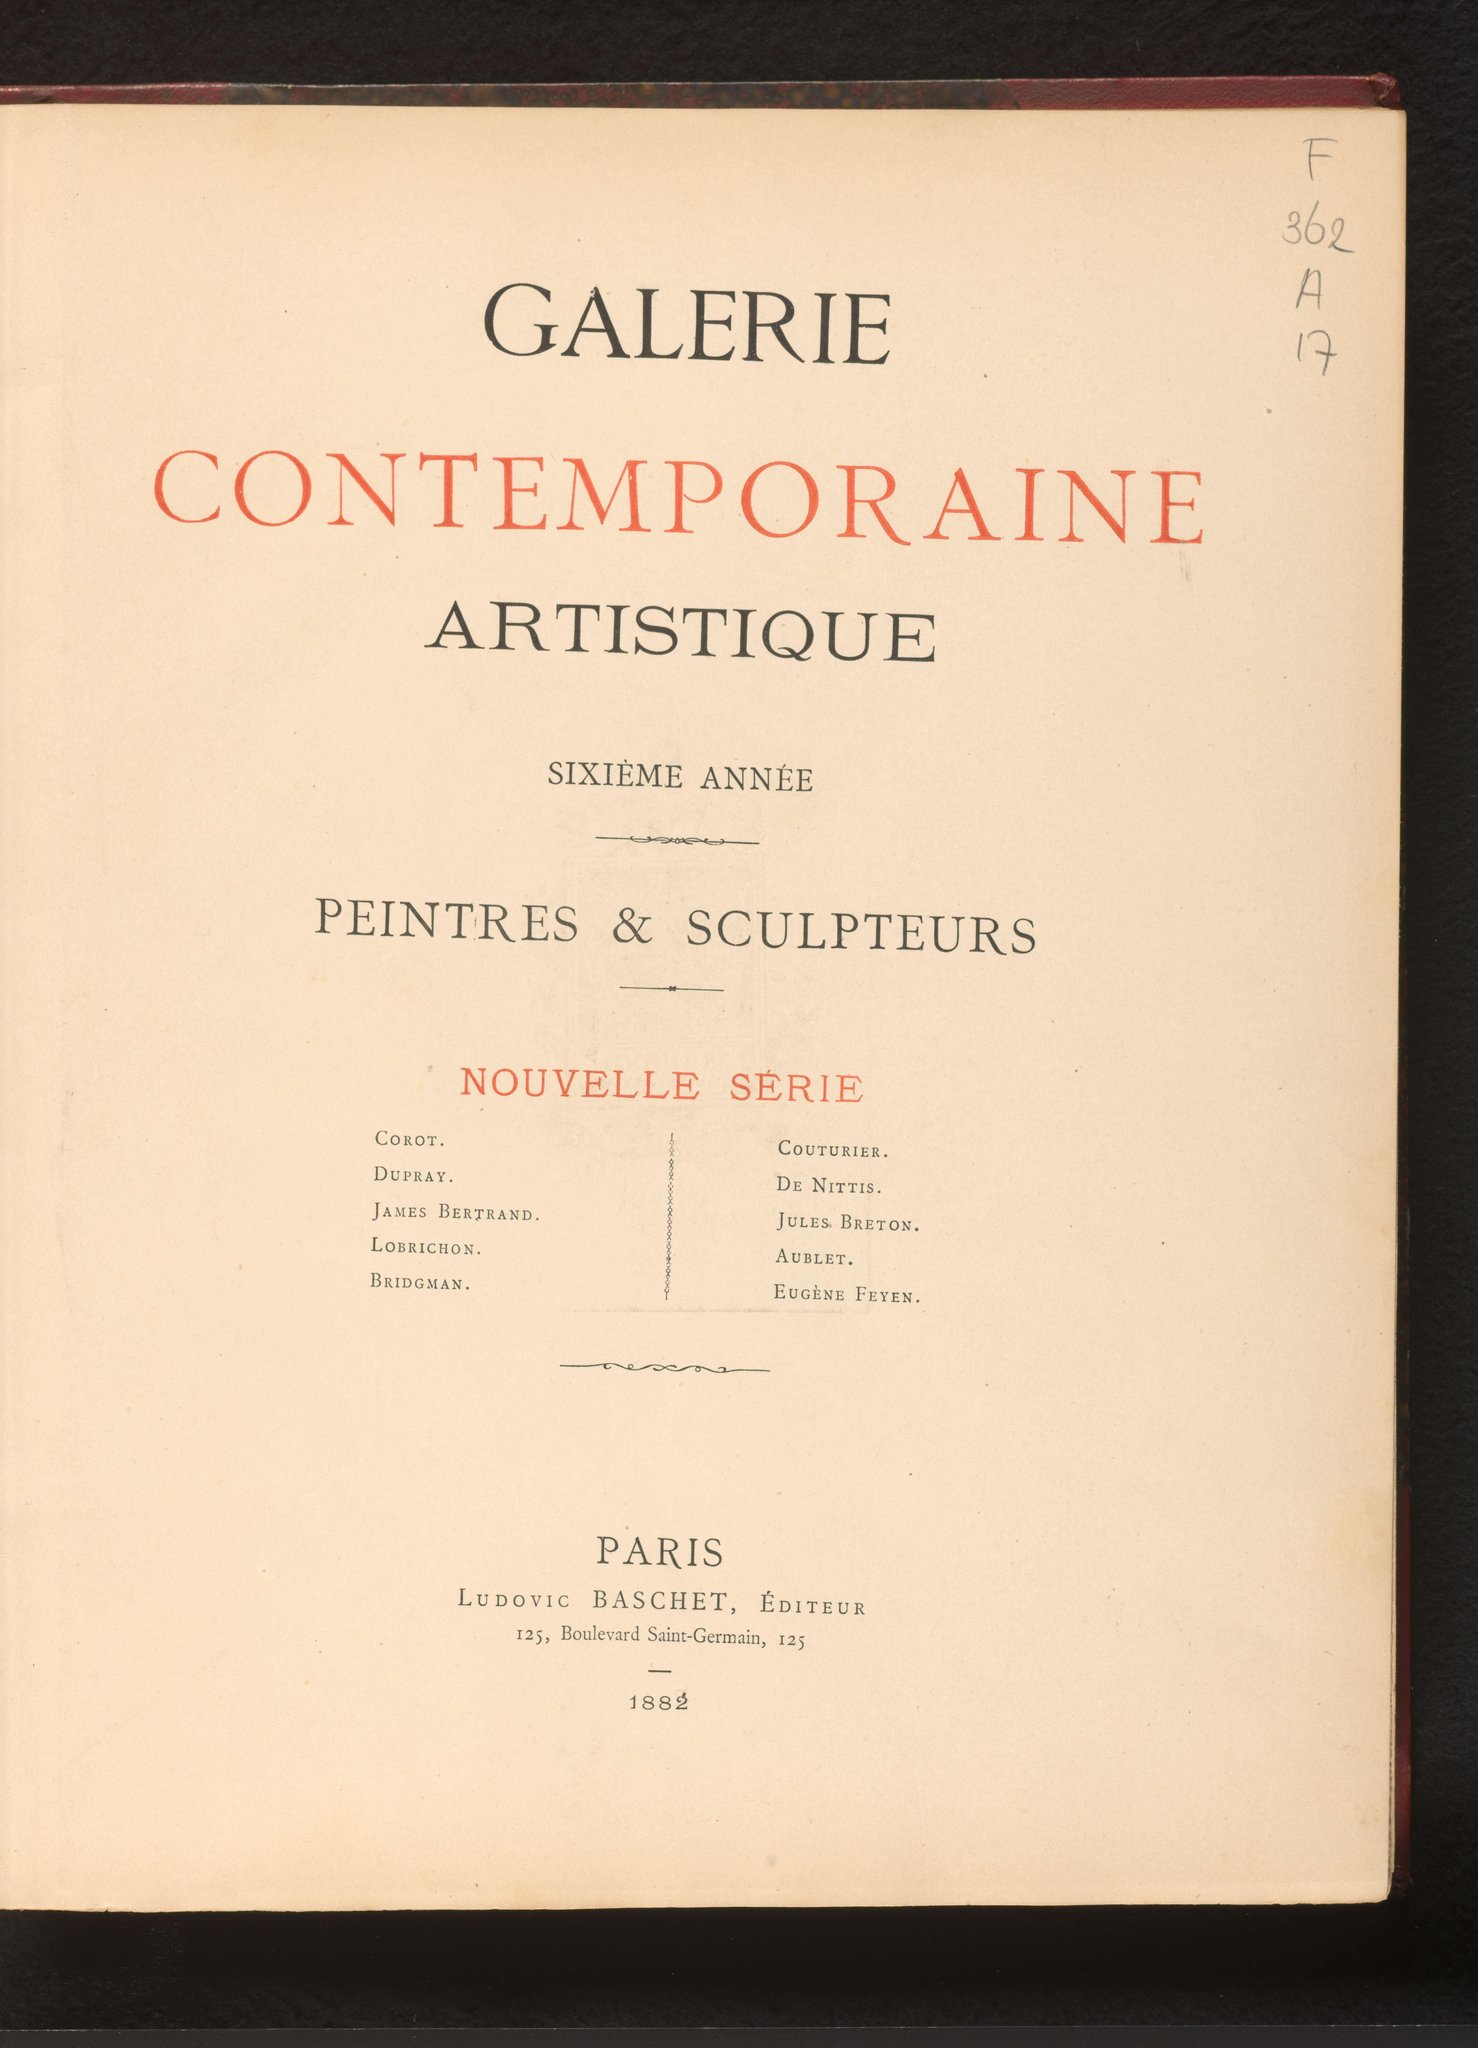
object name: book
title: Galerie contemporaine artistique : peintres et sculpteurs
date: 1882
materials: cardboard, leather, paper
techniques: marbled paper, printing, woodburytype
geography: paris